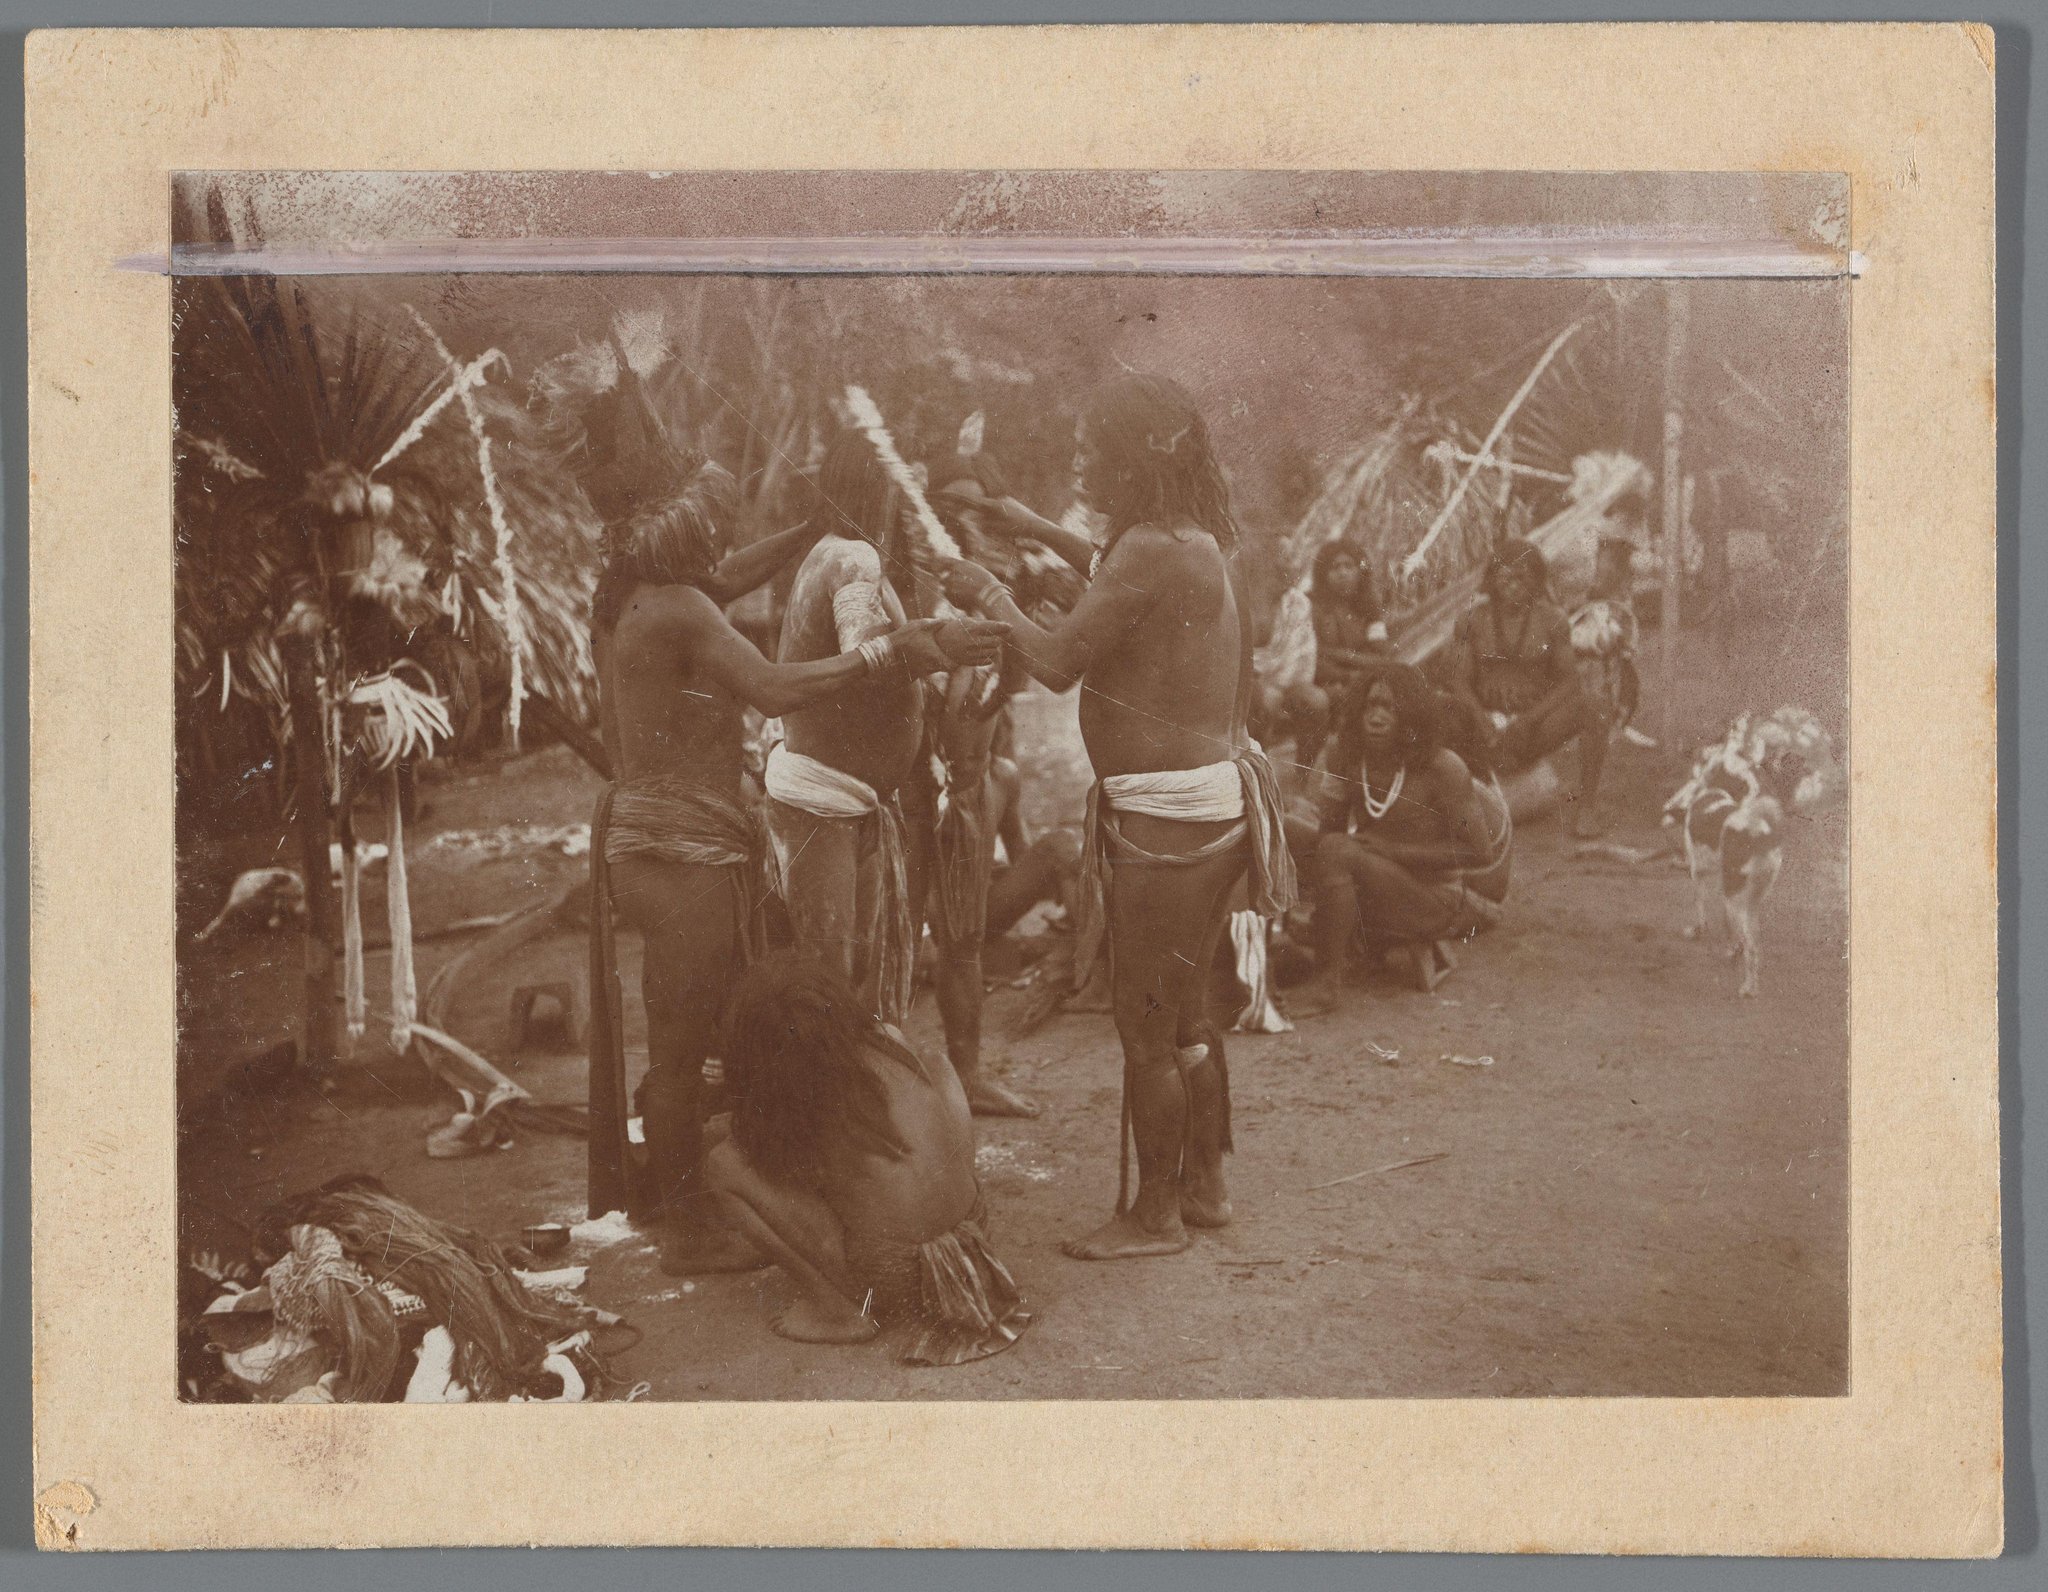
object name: photograph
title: Groepje Indianen bij een rituele dans ten tijde van de Toemoek expeditie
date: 1904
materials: cardboard, photographic support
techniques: collodion silver print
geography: suriname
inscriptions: annotation: ‘Van deze foto 1 c. M. afnemen ( boven) en 10 c. M breed, zooals nu de cliché's zijn, wordt de totale hoogte meer als 18 1/2 c. M, daar moet [?] minstens 1 C. m. wit tusschen, moet voor de boekdrukteksten 24916’, annotation: ‘Foto der Toemoekhoemak-expeditie.’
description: Groepje Indianen nabij de Tapanahoni-rivier in Suriname ten tijde van de Toemoek-expeditie of Tapanahoni-expeditie die werd geinitieerd door onder andere door het Koninklijk Nederlands Aardrijkskundig Genootschap